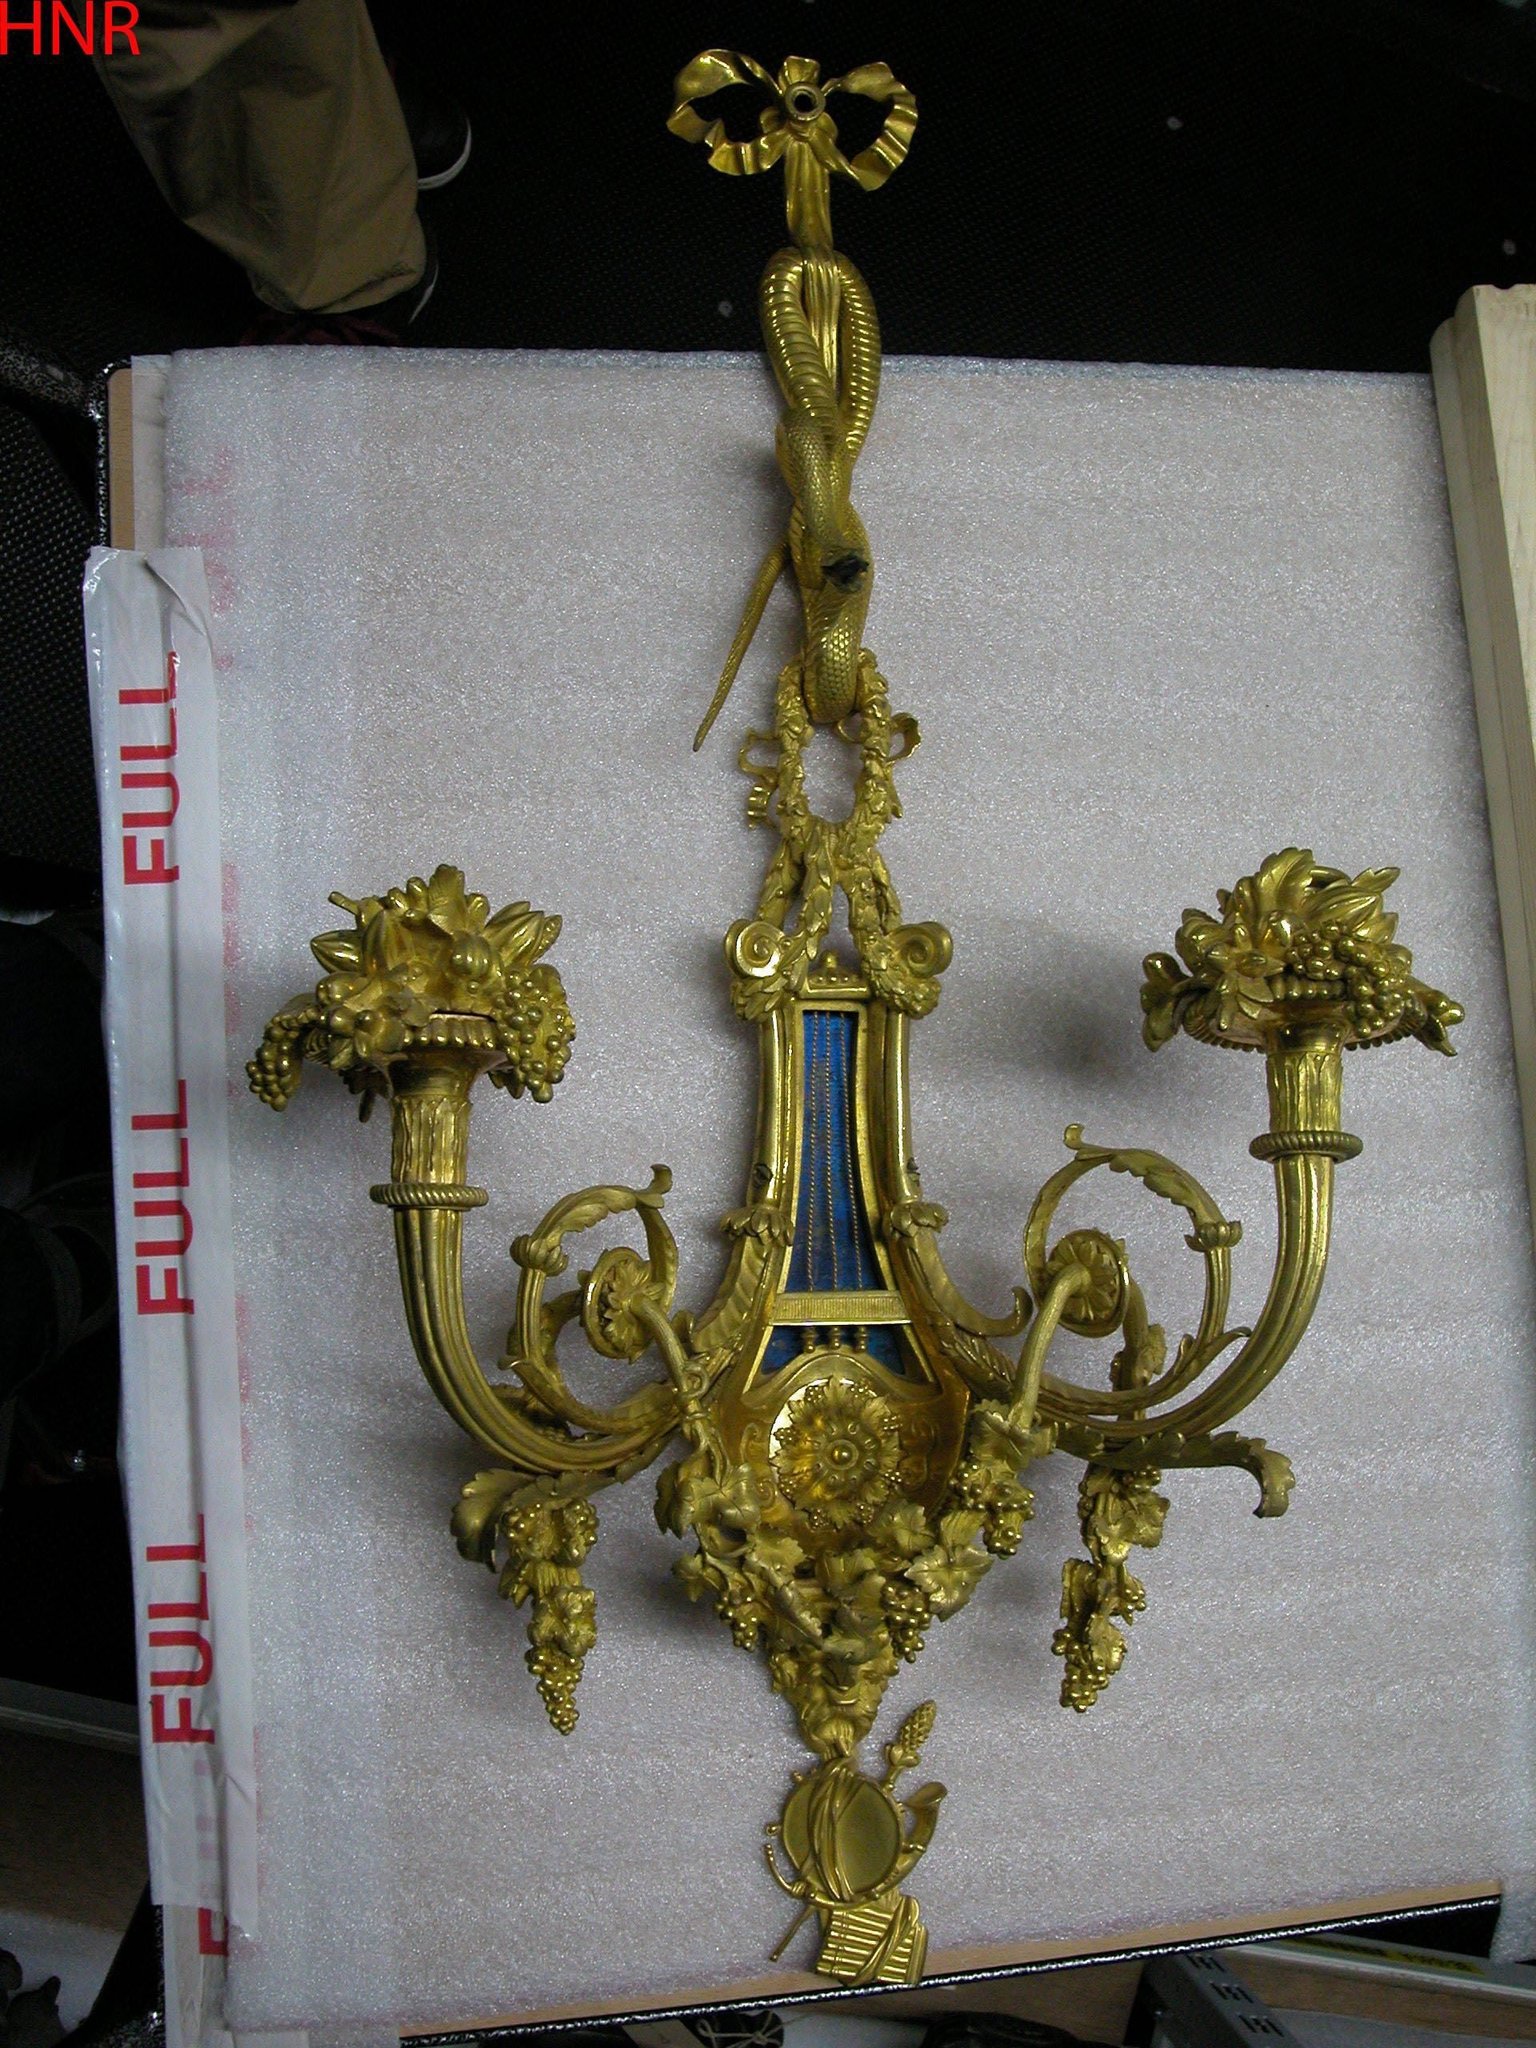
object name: furniture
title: Wandarm van verguld brons met twee armen en liervormige stam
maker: Anonymous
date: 1775-1800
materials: bronze, iron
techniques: gilding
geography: france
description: Two wall-lights. Gilt bronze. Paris, c. 1780.